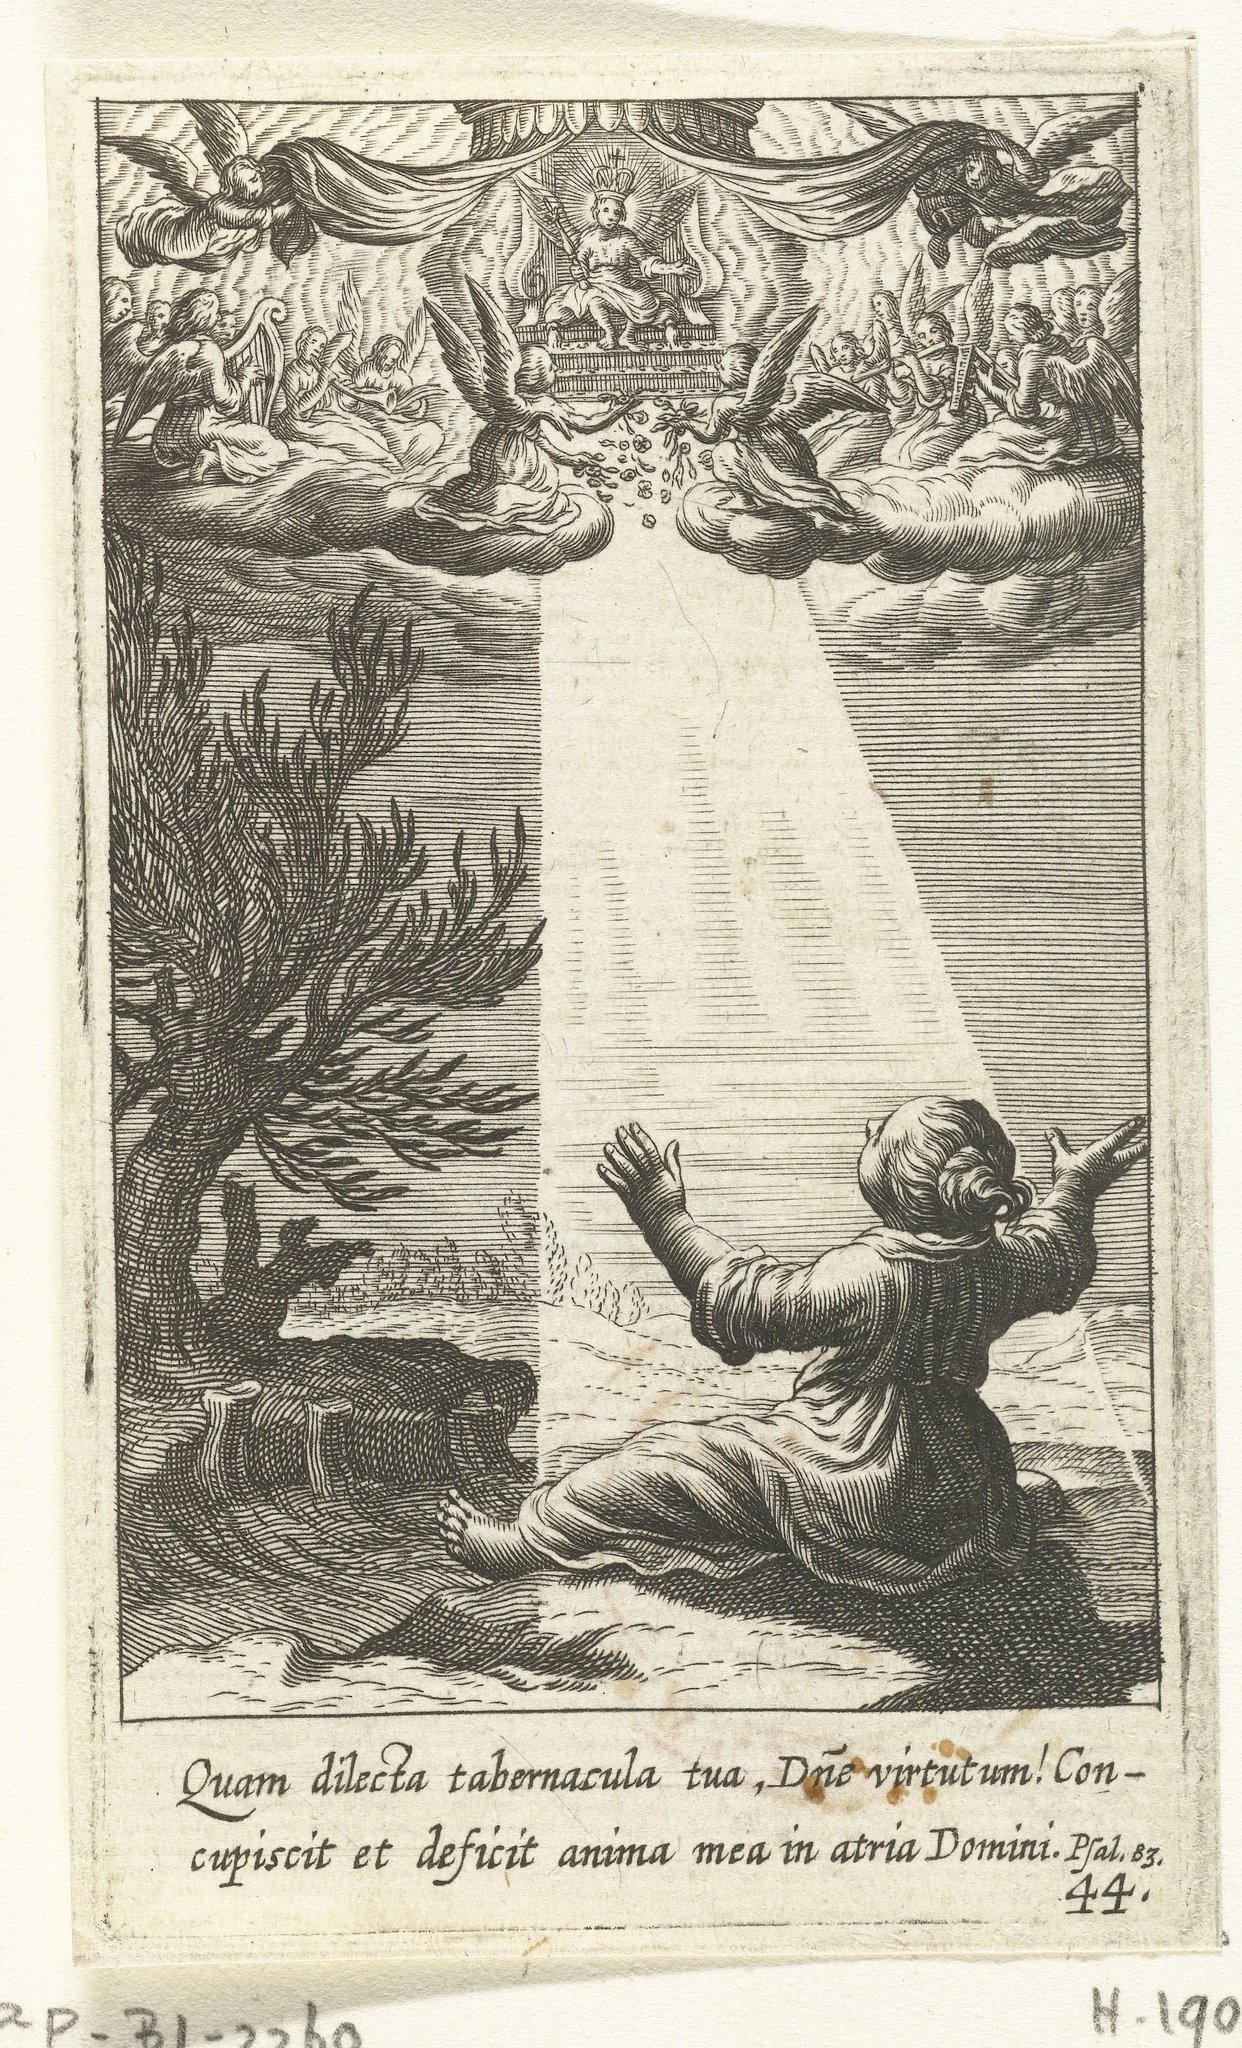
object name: book illustration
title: Kind op aarde zit in lichtstralen van tronende engel in hemel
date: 1590-1624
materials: paper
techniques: engraving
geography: antwerp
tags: angels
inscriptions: collector's mark: Lugt 240, inscription: ‘Quàm dilecta tabernacula tua Domine virtutum! concupiscit et deficit anima mea in atria Domini.’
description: Boekillustratie uit: Herman Hugo, Pia desideria emblematis, elegiis & affectibus S. S. Patrum illustrata, Antwerpen 1624, afb. 44